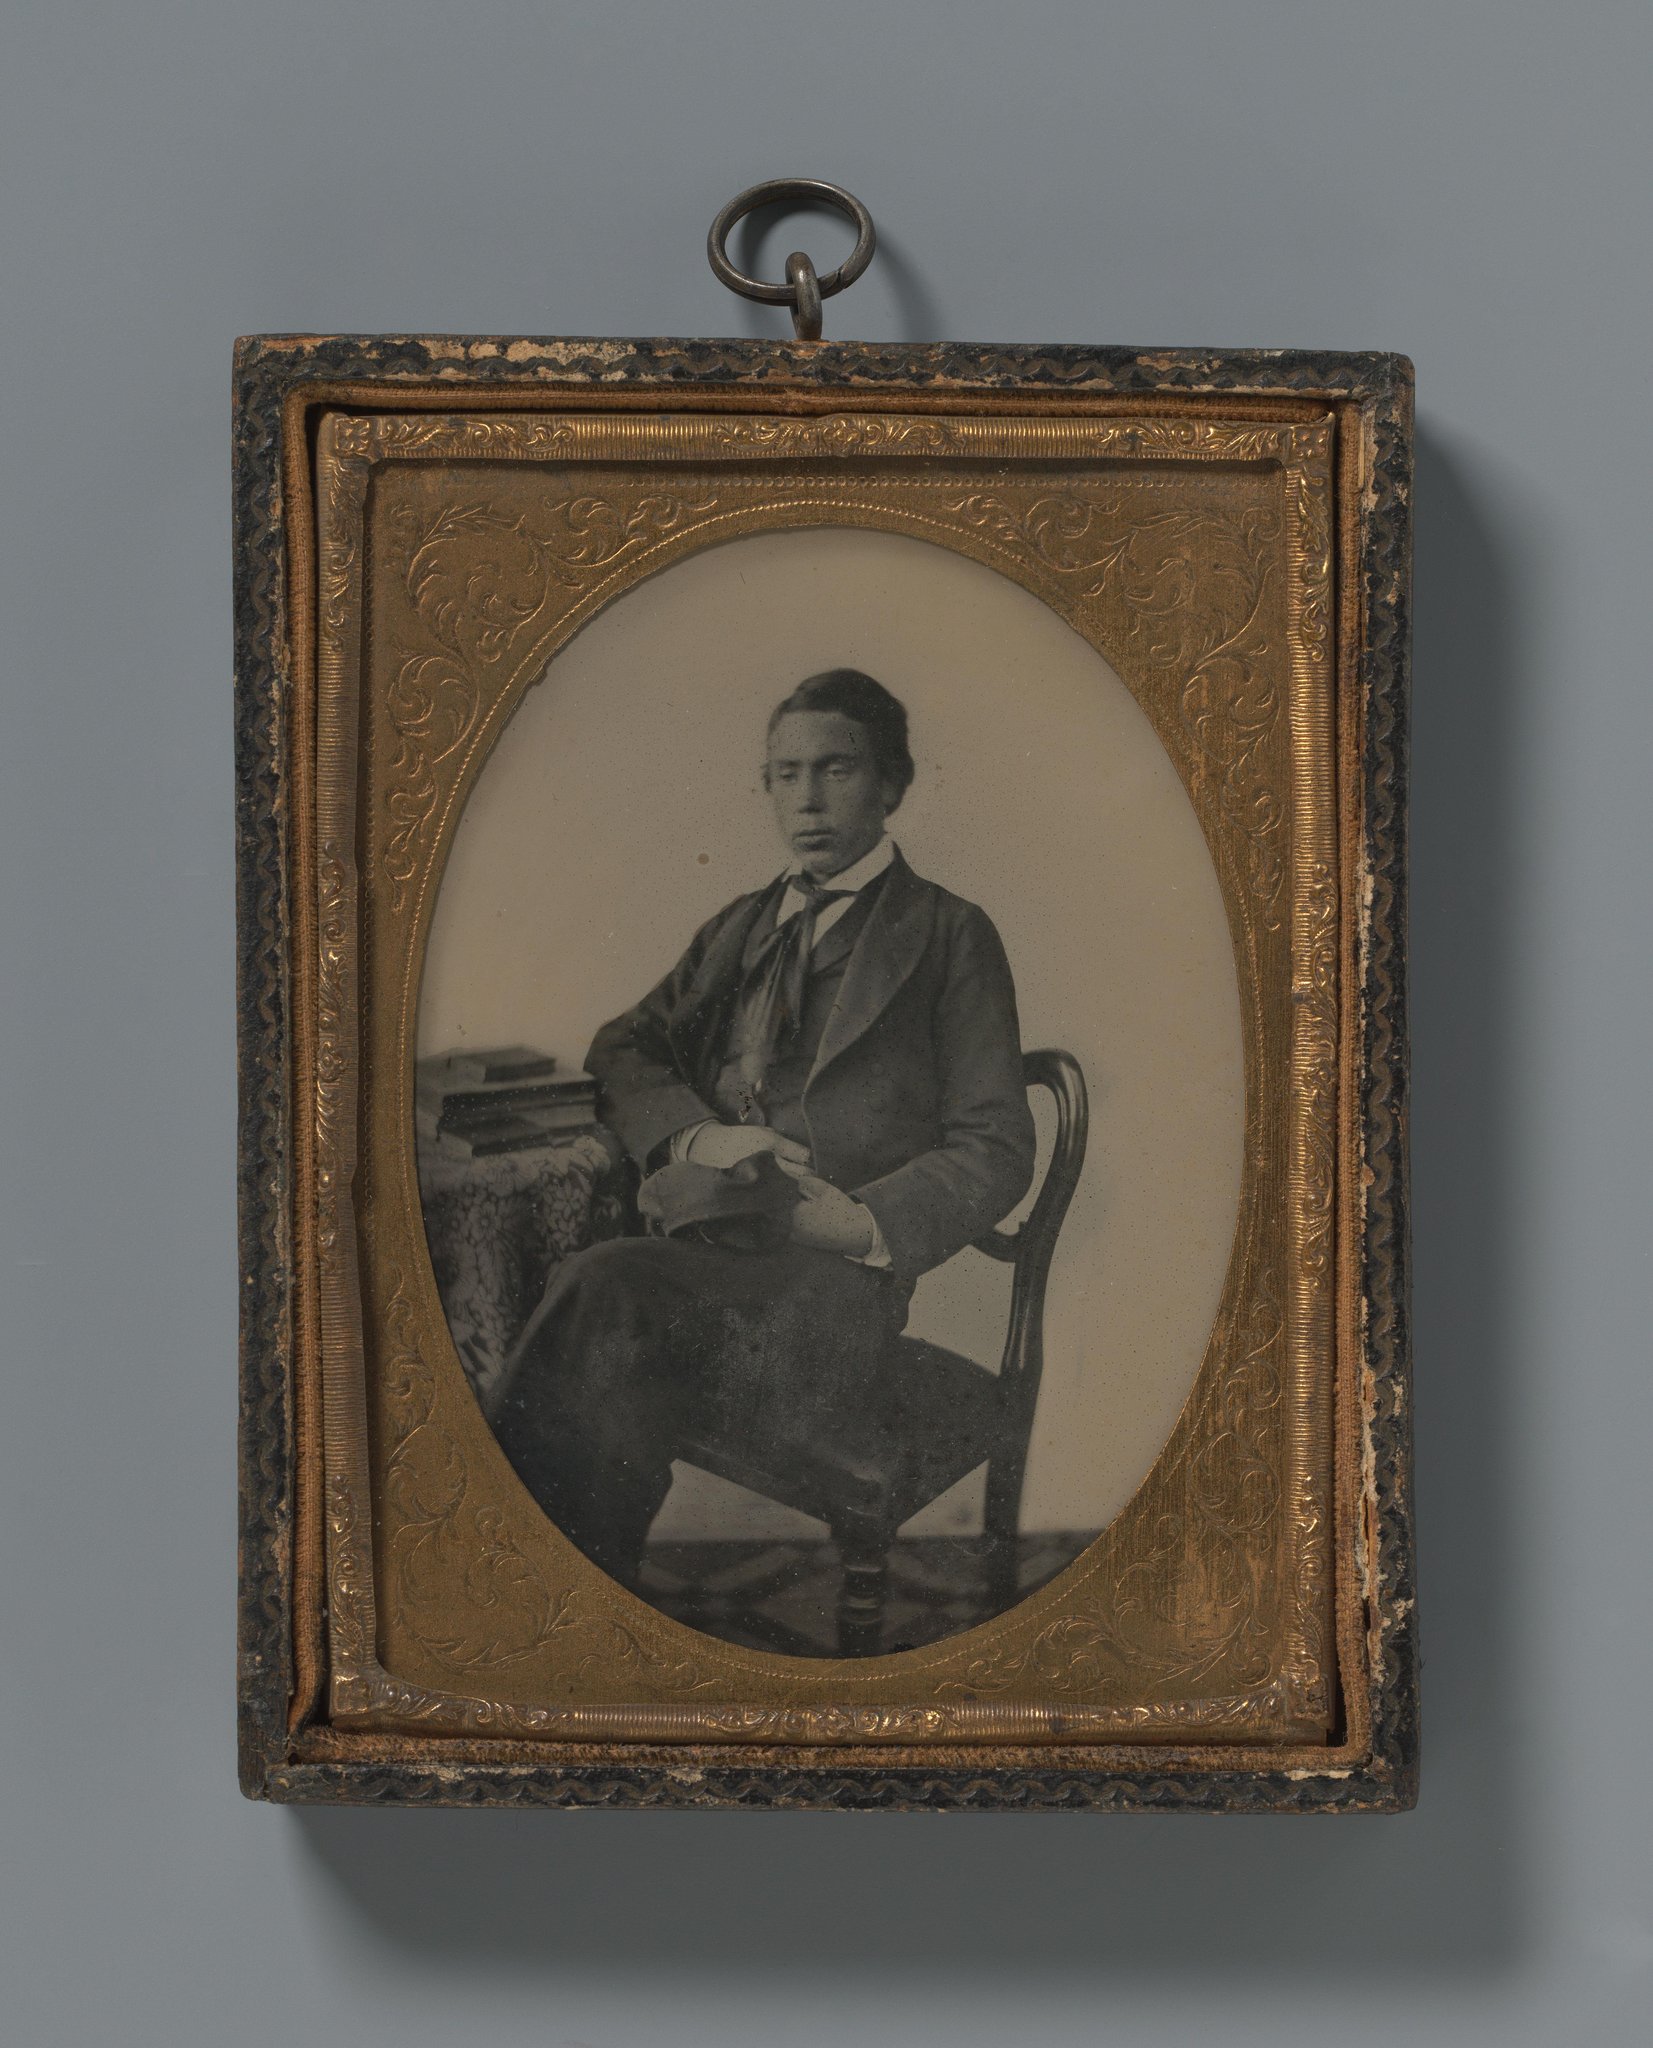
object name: photograph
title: Portret van een onbekende jongeman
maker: Anonymous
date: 1855-1870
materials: glass, metal, paper, wood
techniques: ambrotype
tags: historical persons, youth, adolescent